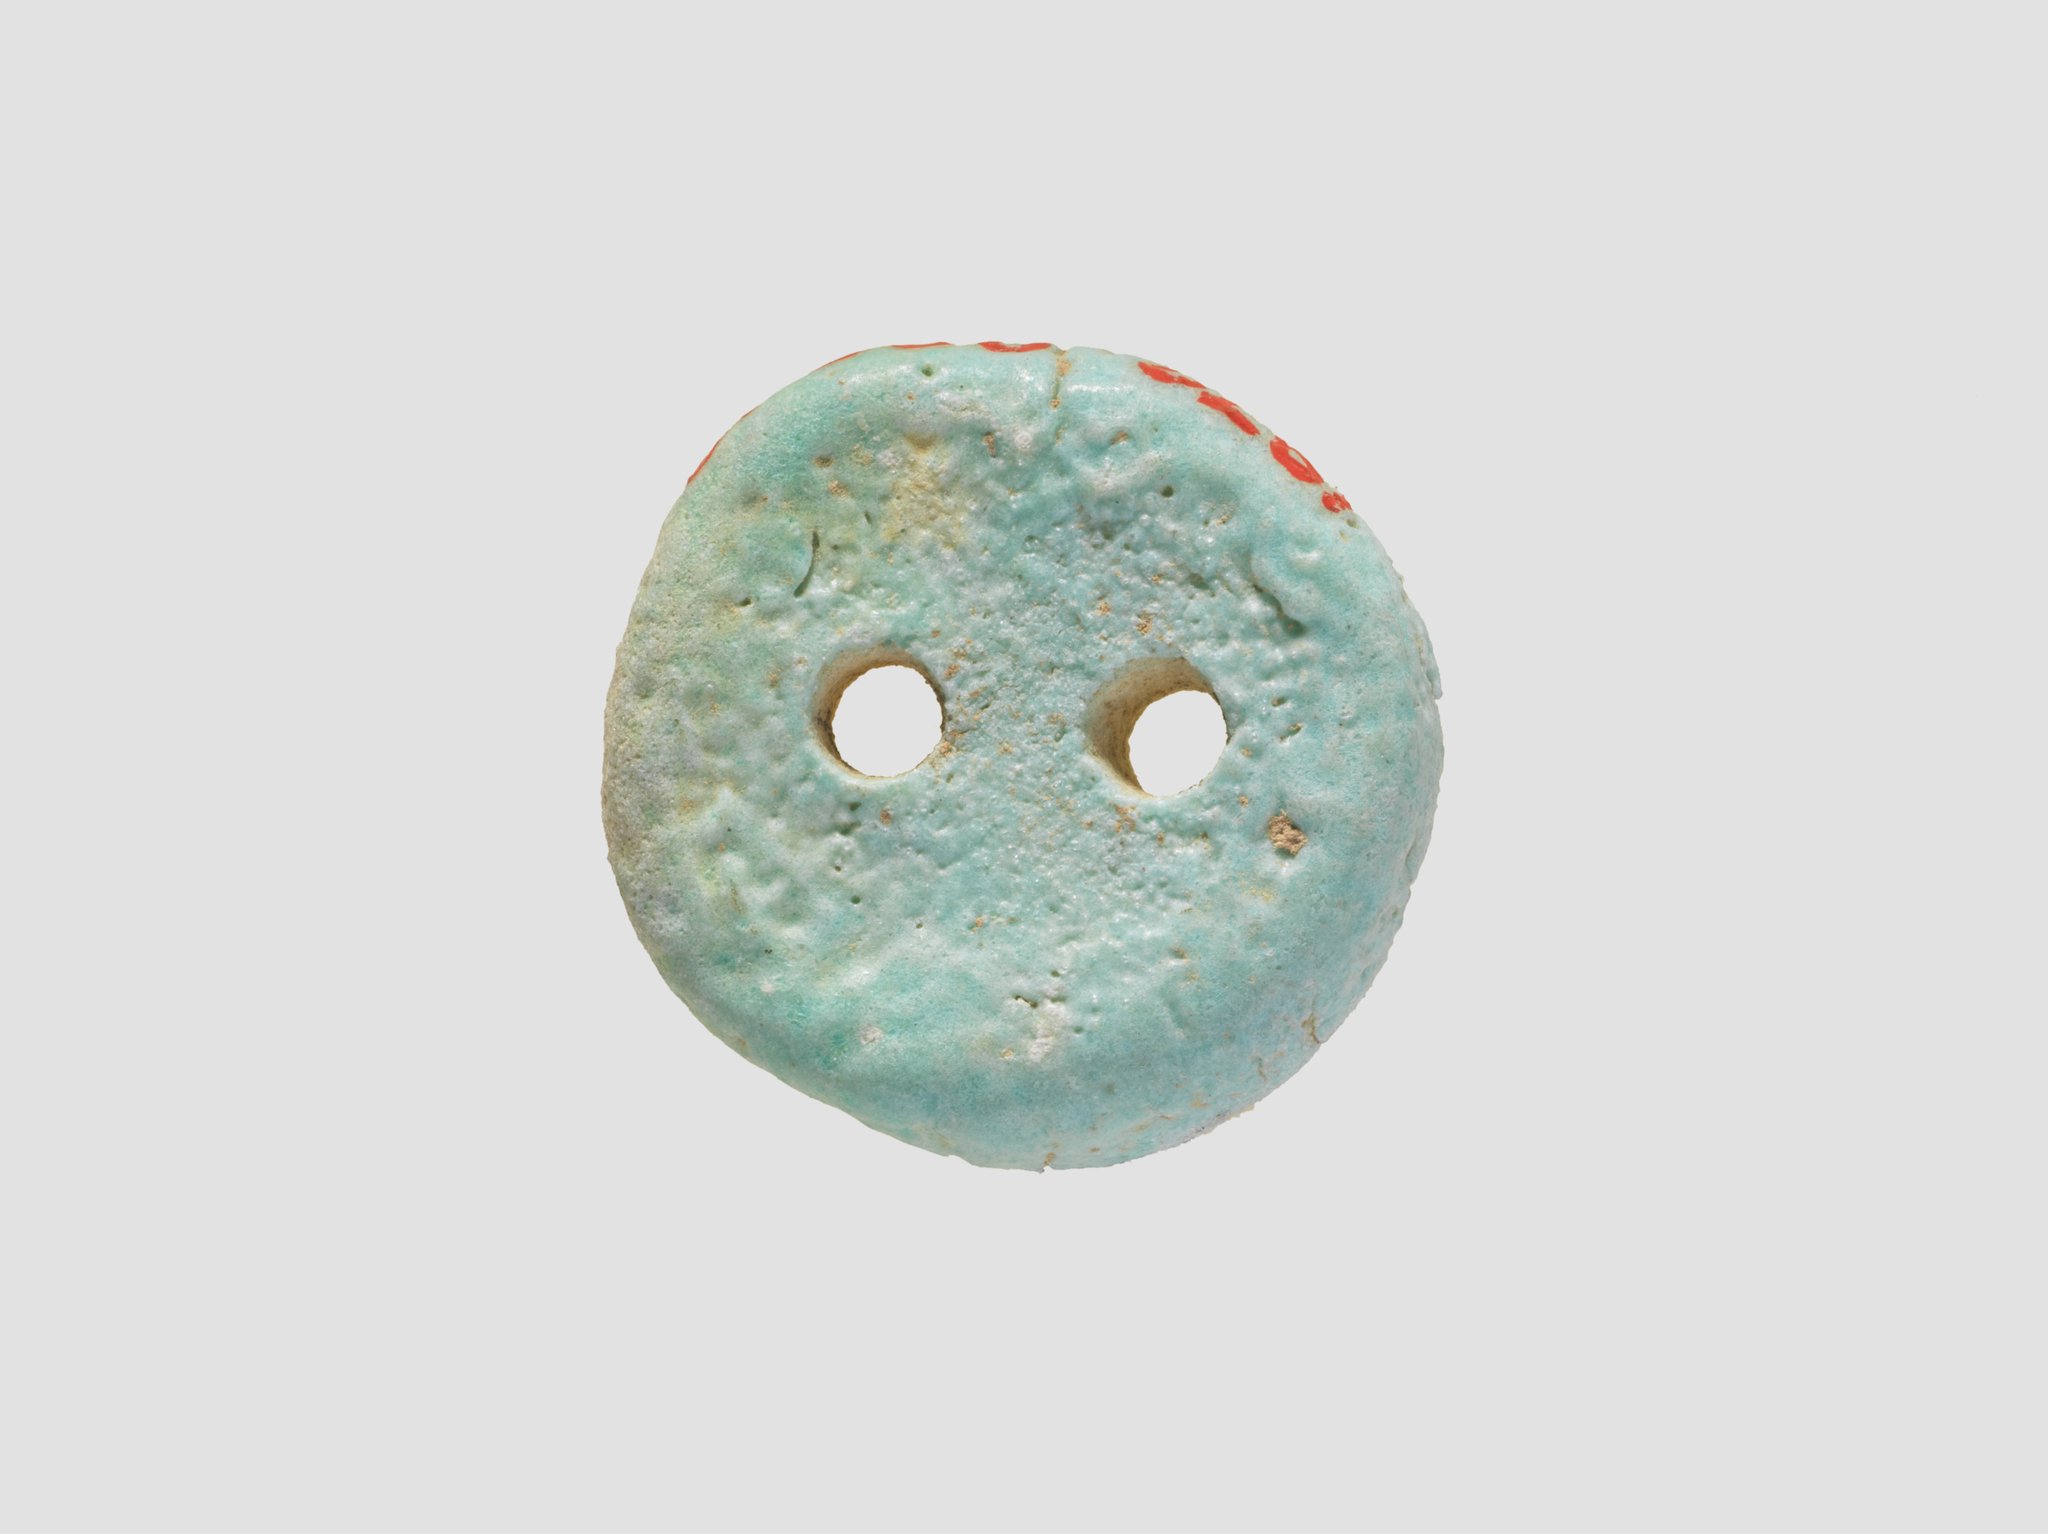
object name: ornament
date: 2333-2001 BCE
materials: faience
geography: mesopotamia